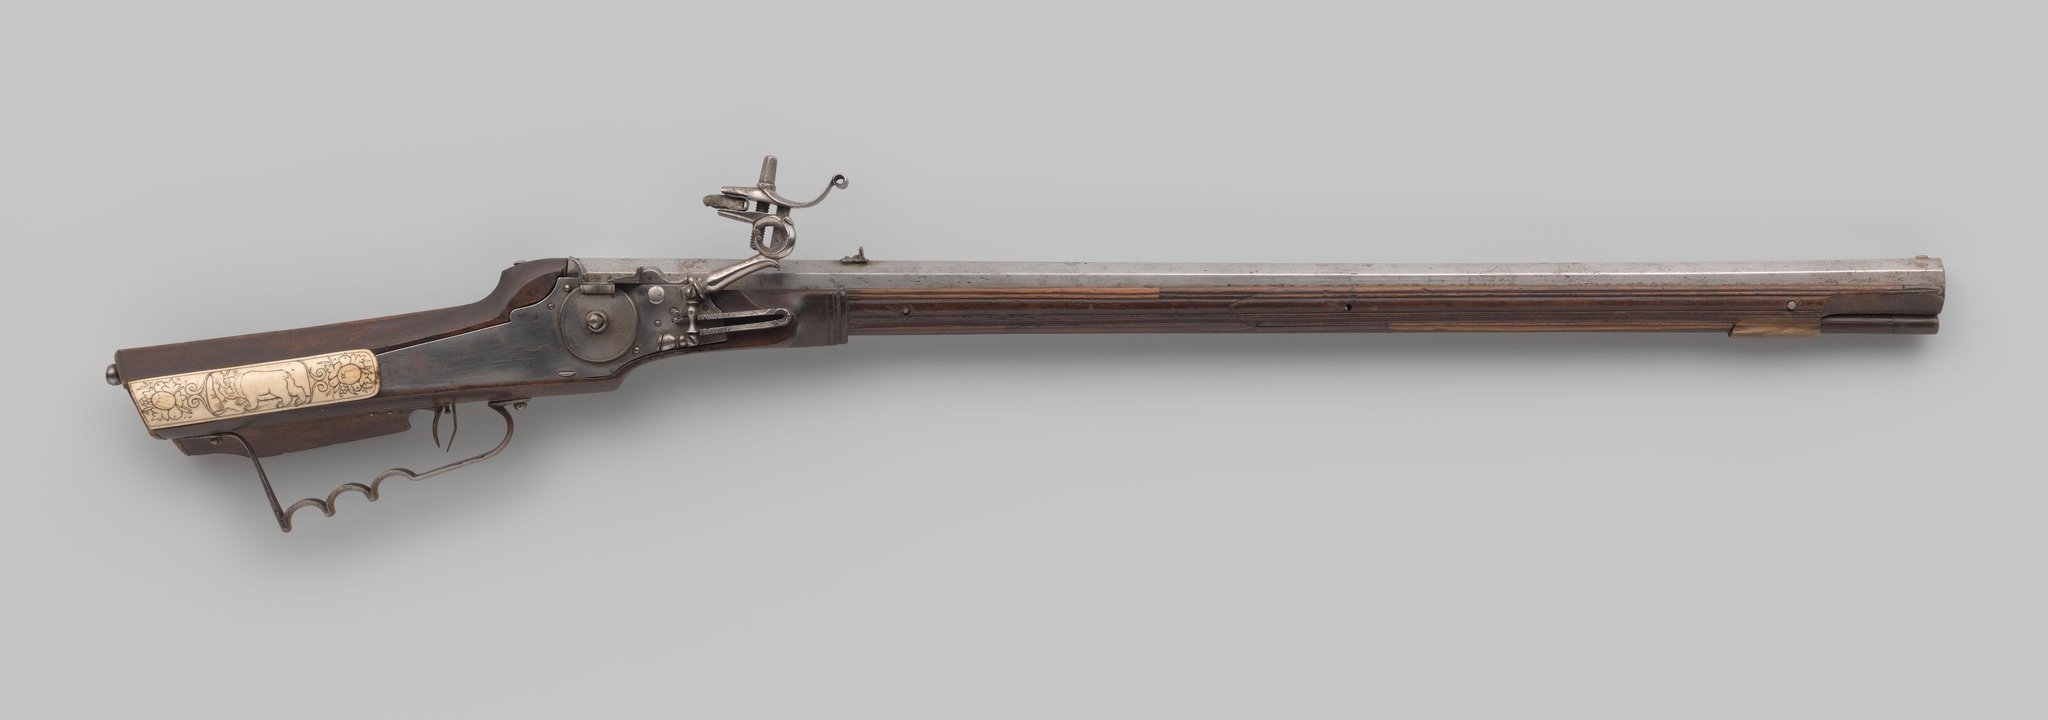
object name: radslotkarabijn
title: Radslotgeweer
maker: Anonymous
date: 1600-1650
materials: bone, horn, iron, wood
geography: germany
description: Jachtgeweer. Loop achtkantig, gemerkt: MAX en niet te ontcijferen stempel, getrokken met negen trekken. Radslot met versneller, rad uitwendig met dekplaat. Kolf met ivoren beer ingelegd. Eerste helft 17de eeuw. Lengte van de loop 0,805 m, kaliber 15 mm.